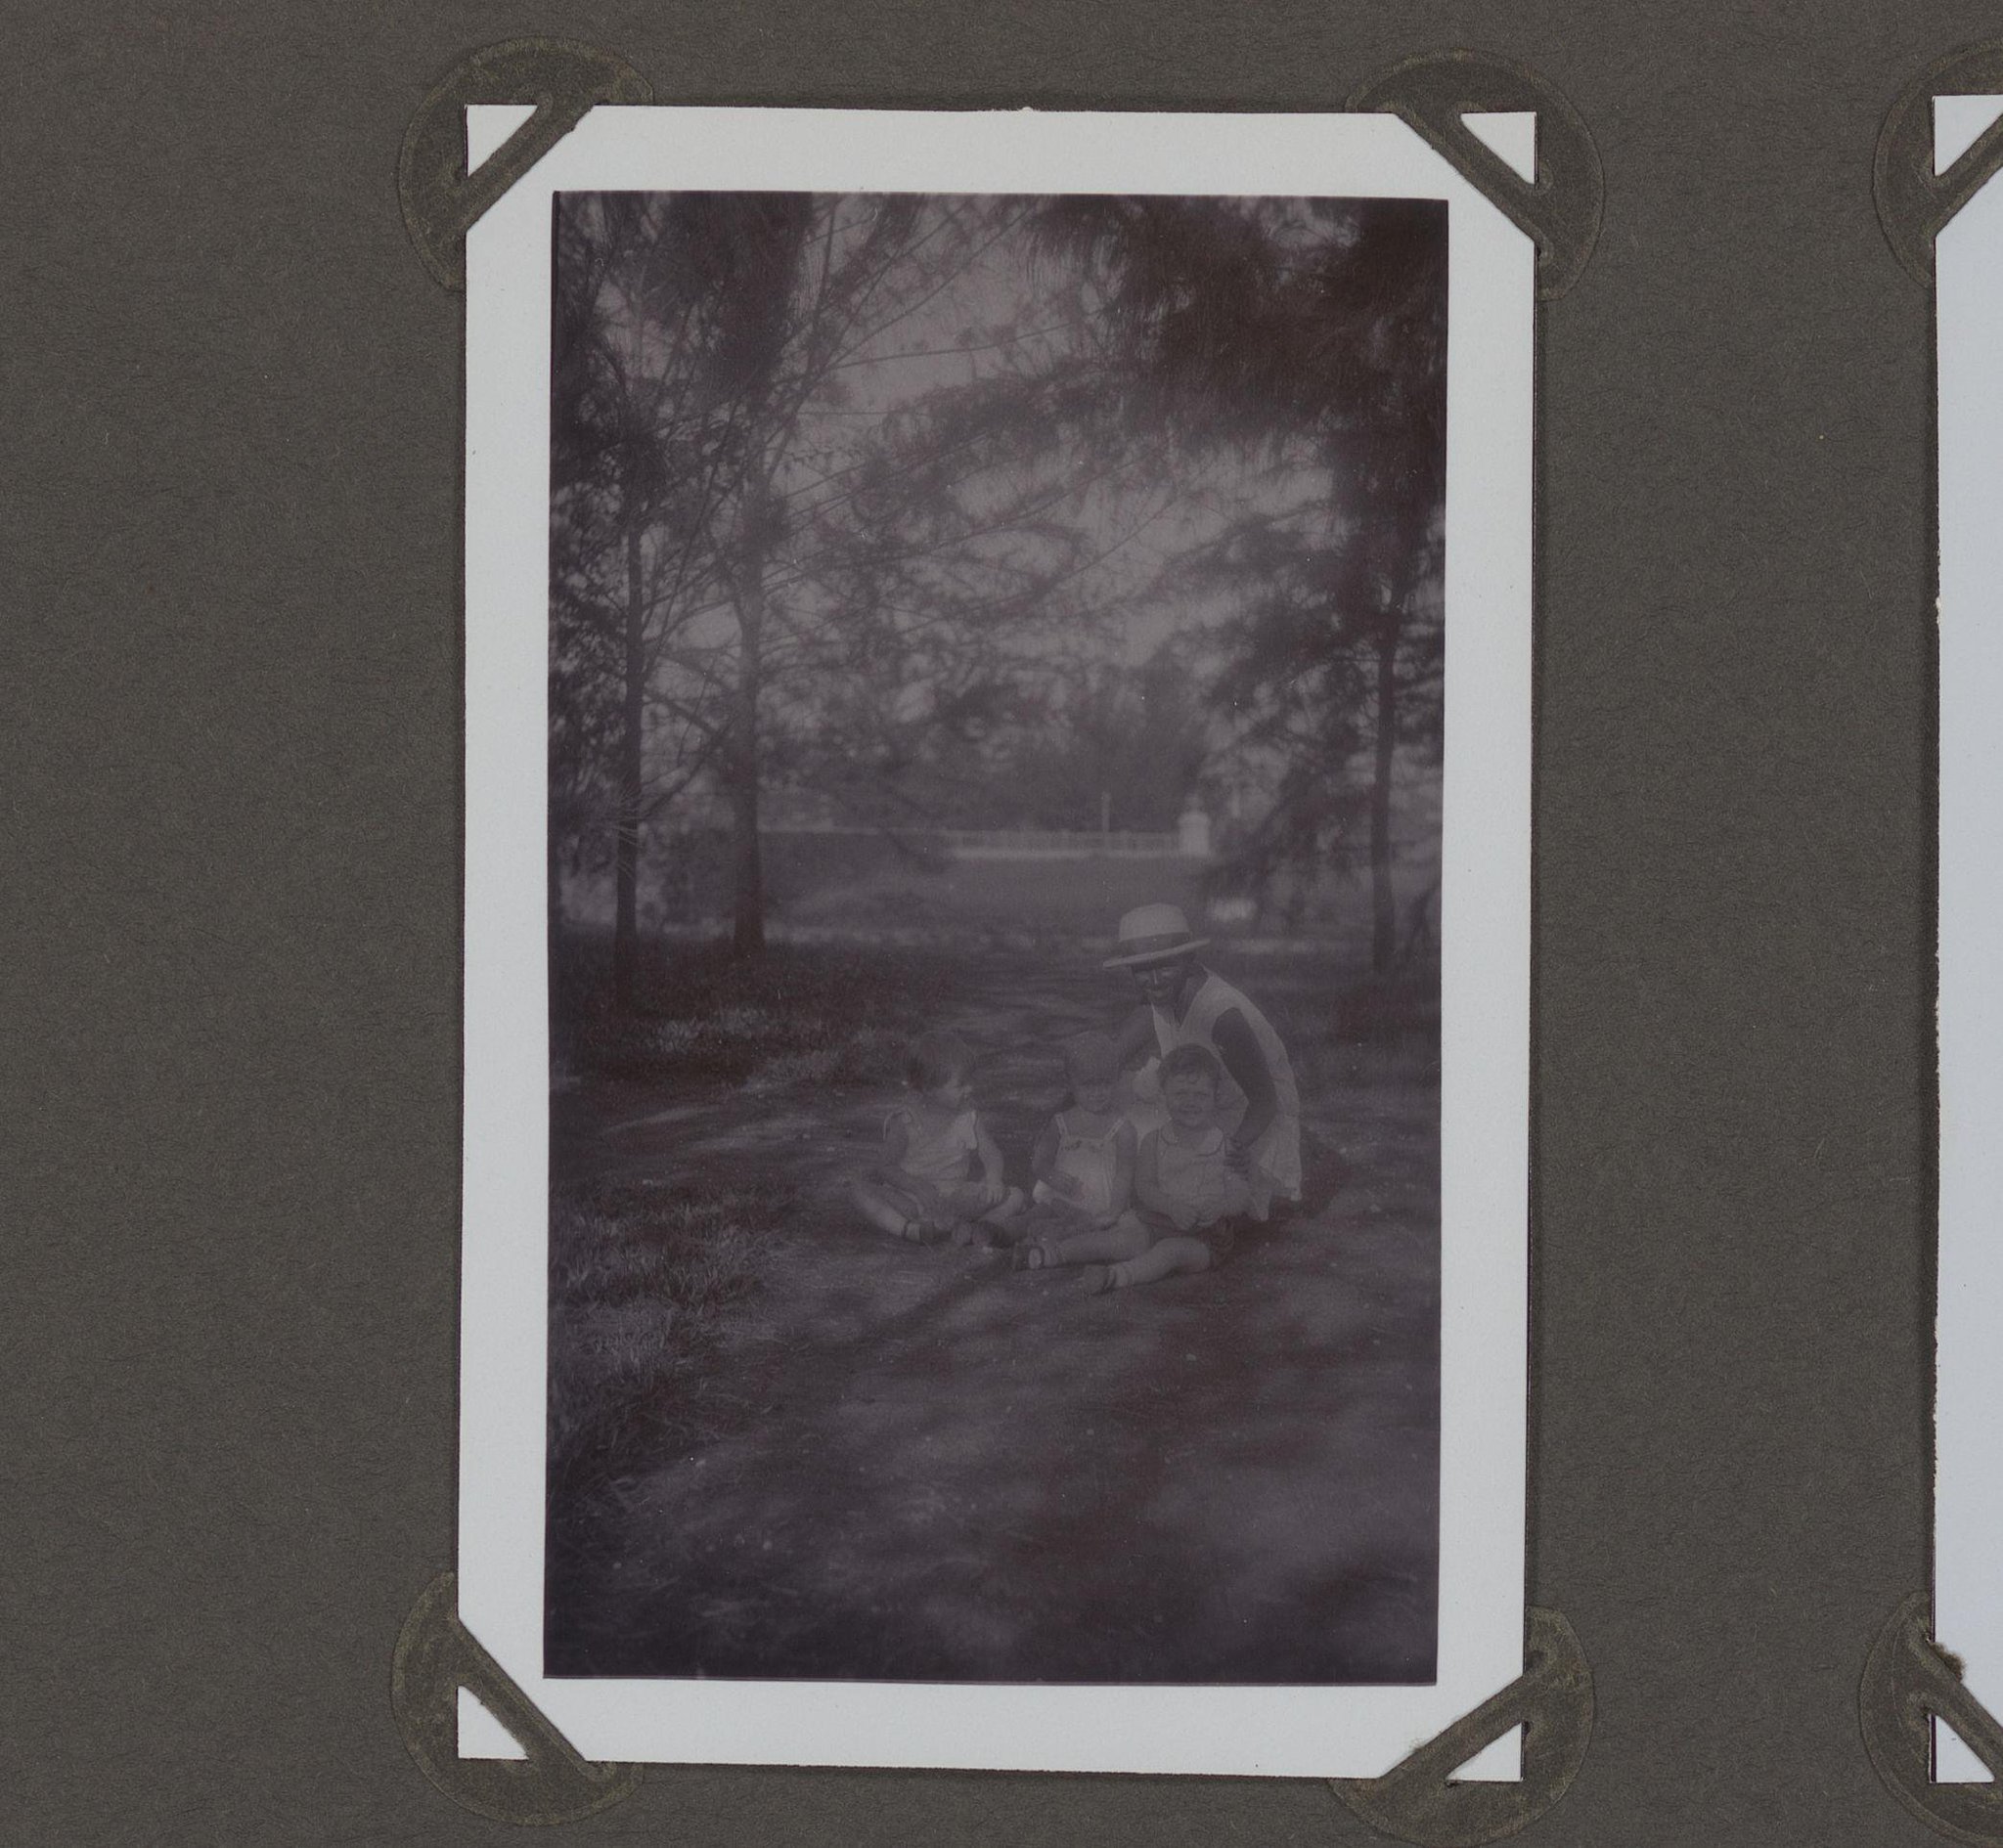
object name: photograph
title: Familiefoto van het gezin Jetten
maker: Anonymous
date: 1925-1927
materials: photographic support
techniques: photography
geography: suriname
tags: jetten, familie, moengo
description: Familiefoto van de kinderen Jetten in Suriname. Foto op een bladzijde van een los albumblad. Onderdeel van het ensemble met foto's van de familie van ingenieur Jetten in de mijnbouwstad Moengo in Suriname.